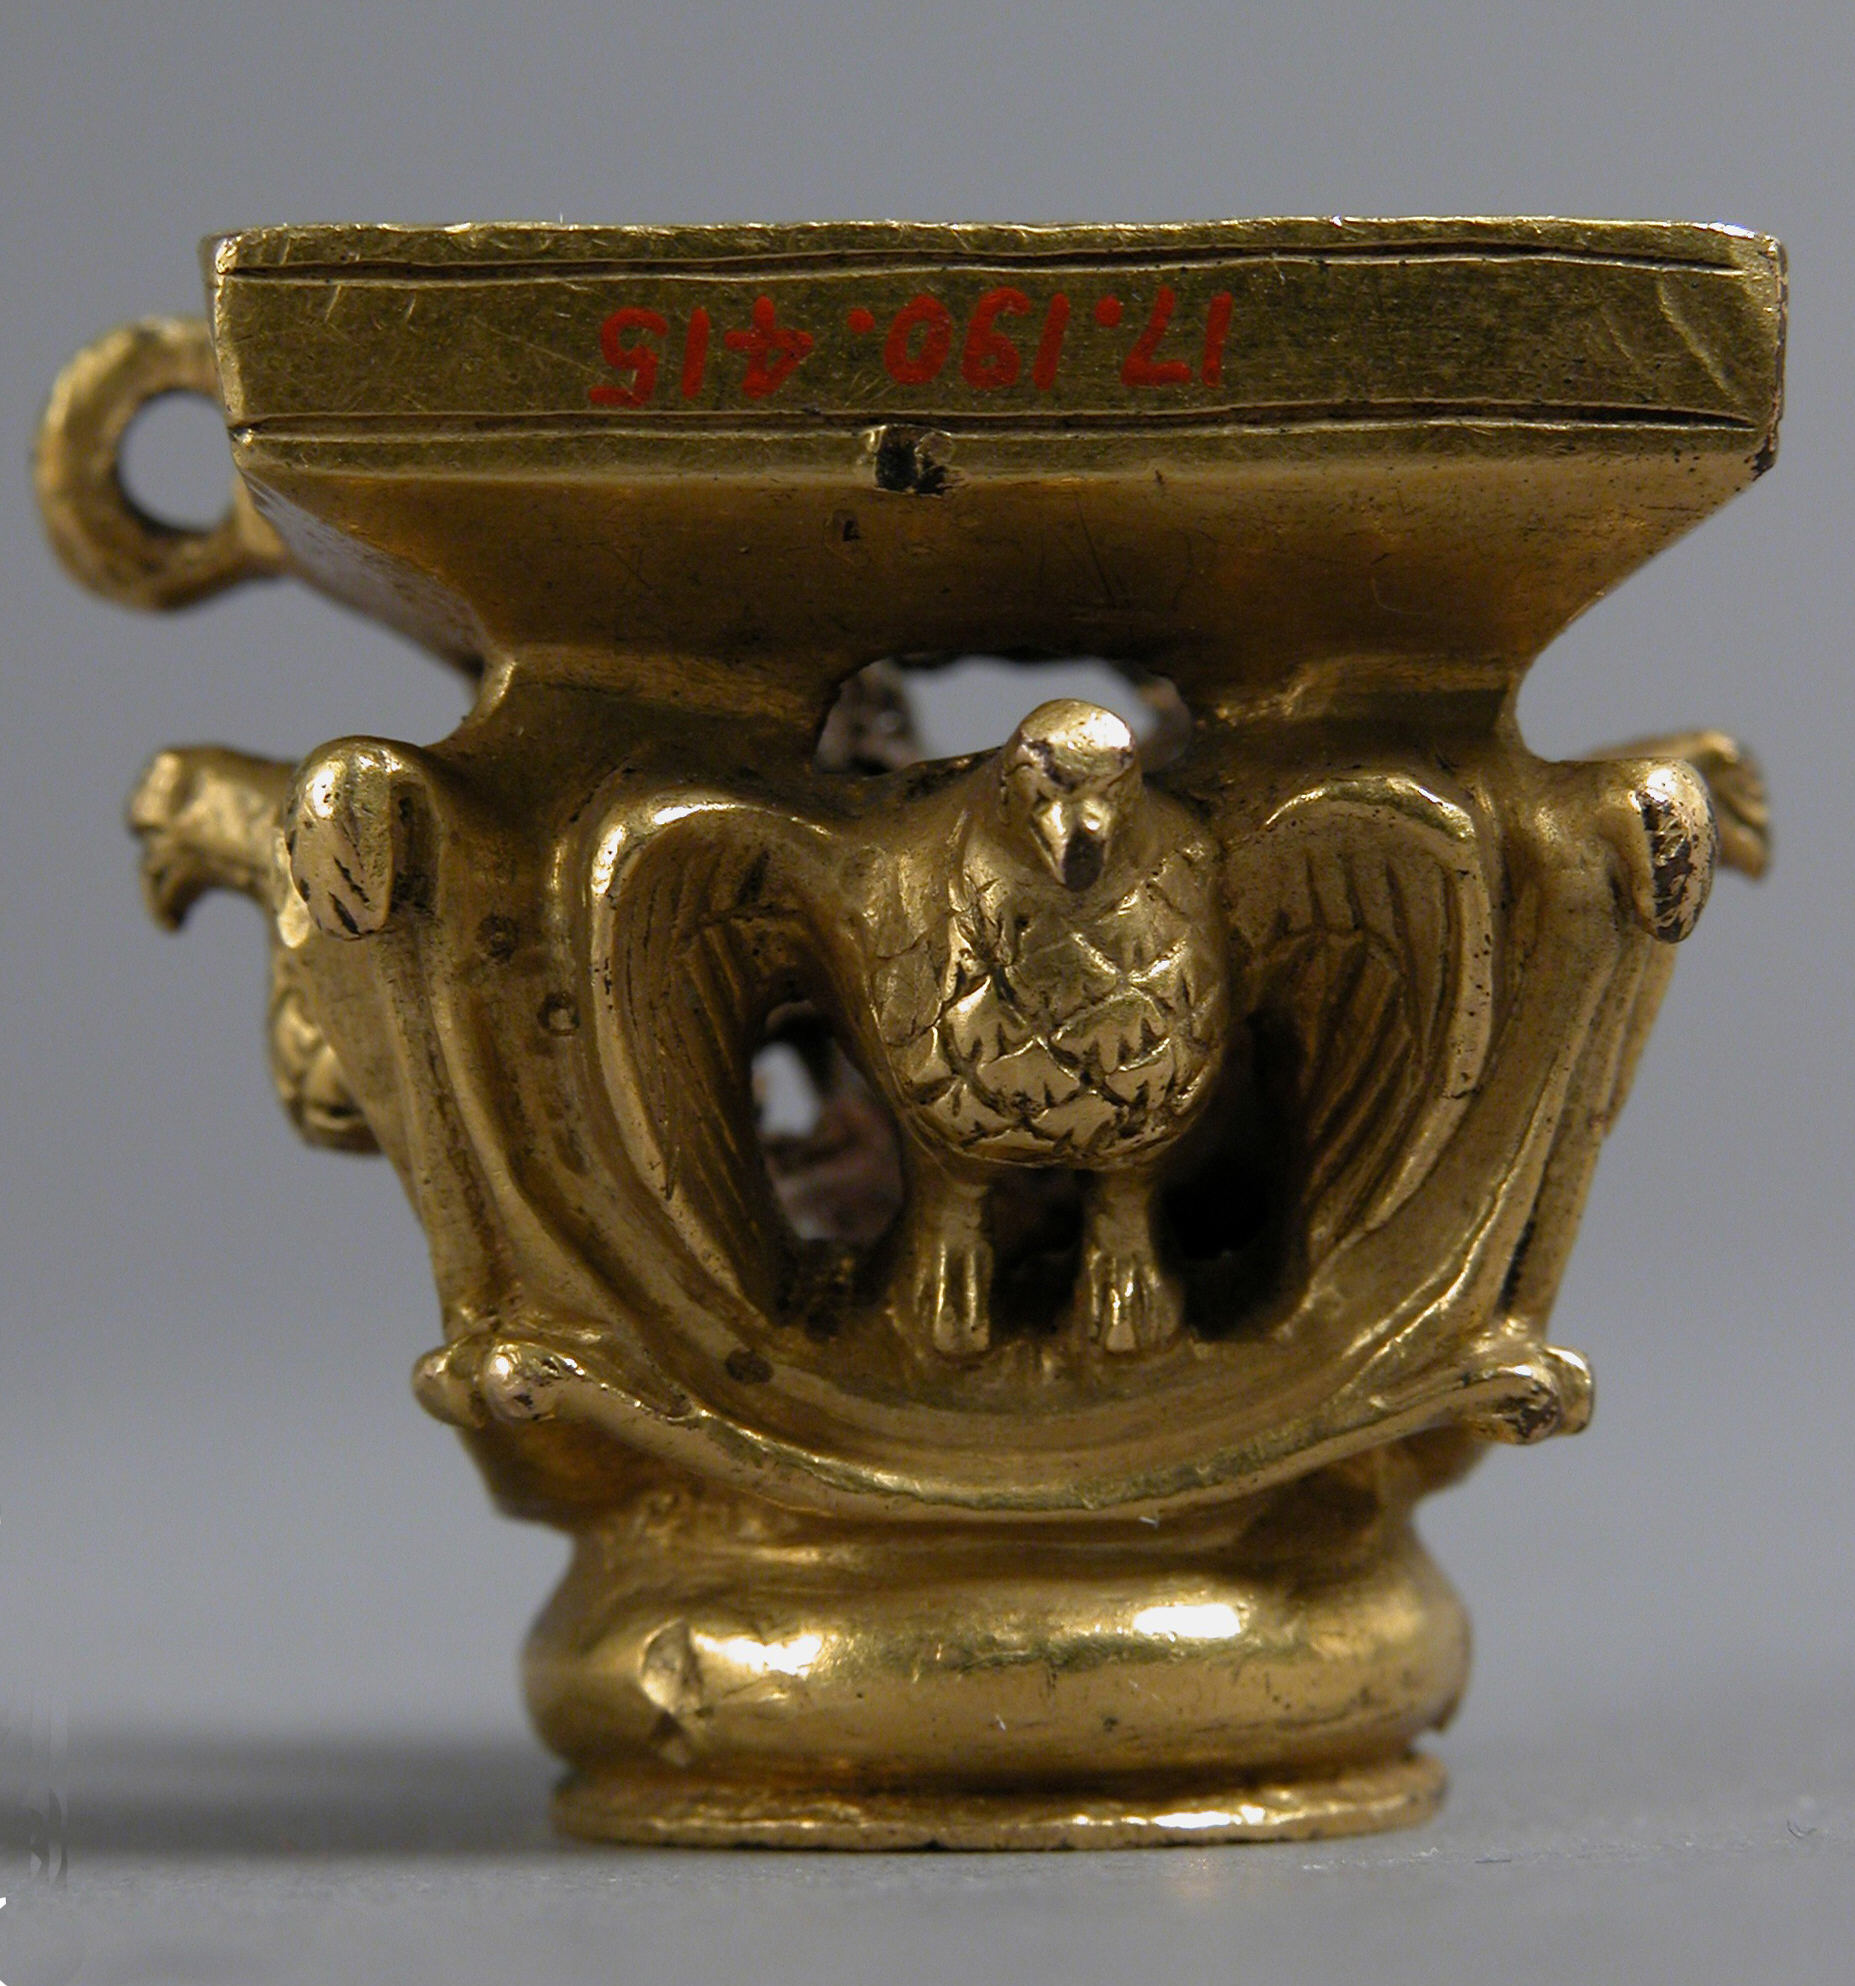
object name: capital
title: Capital from a Reliquary Shrine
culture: german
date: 1175-1200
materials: copper alloy, gilt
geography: germany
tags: birds